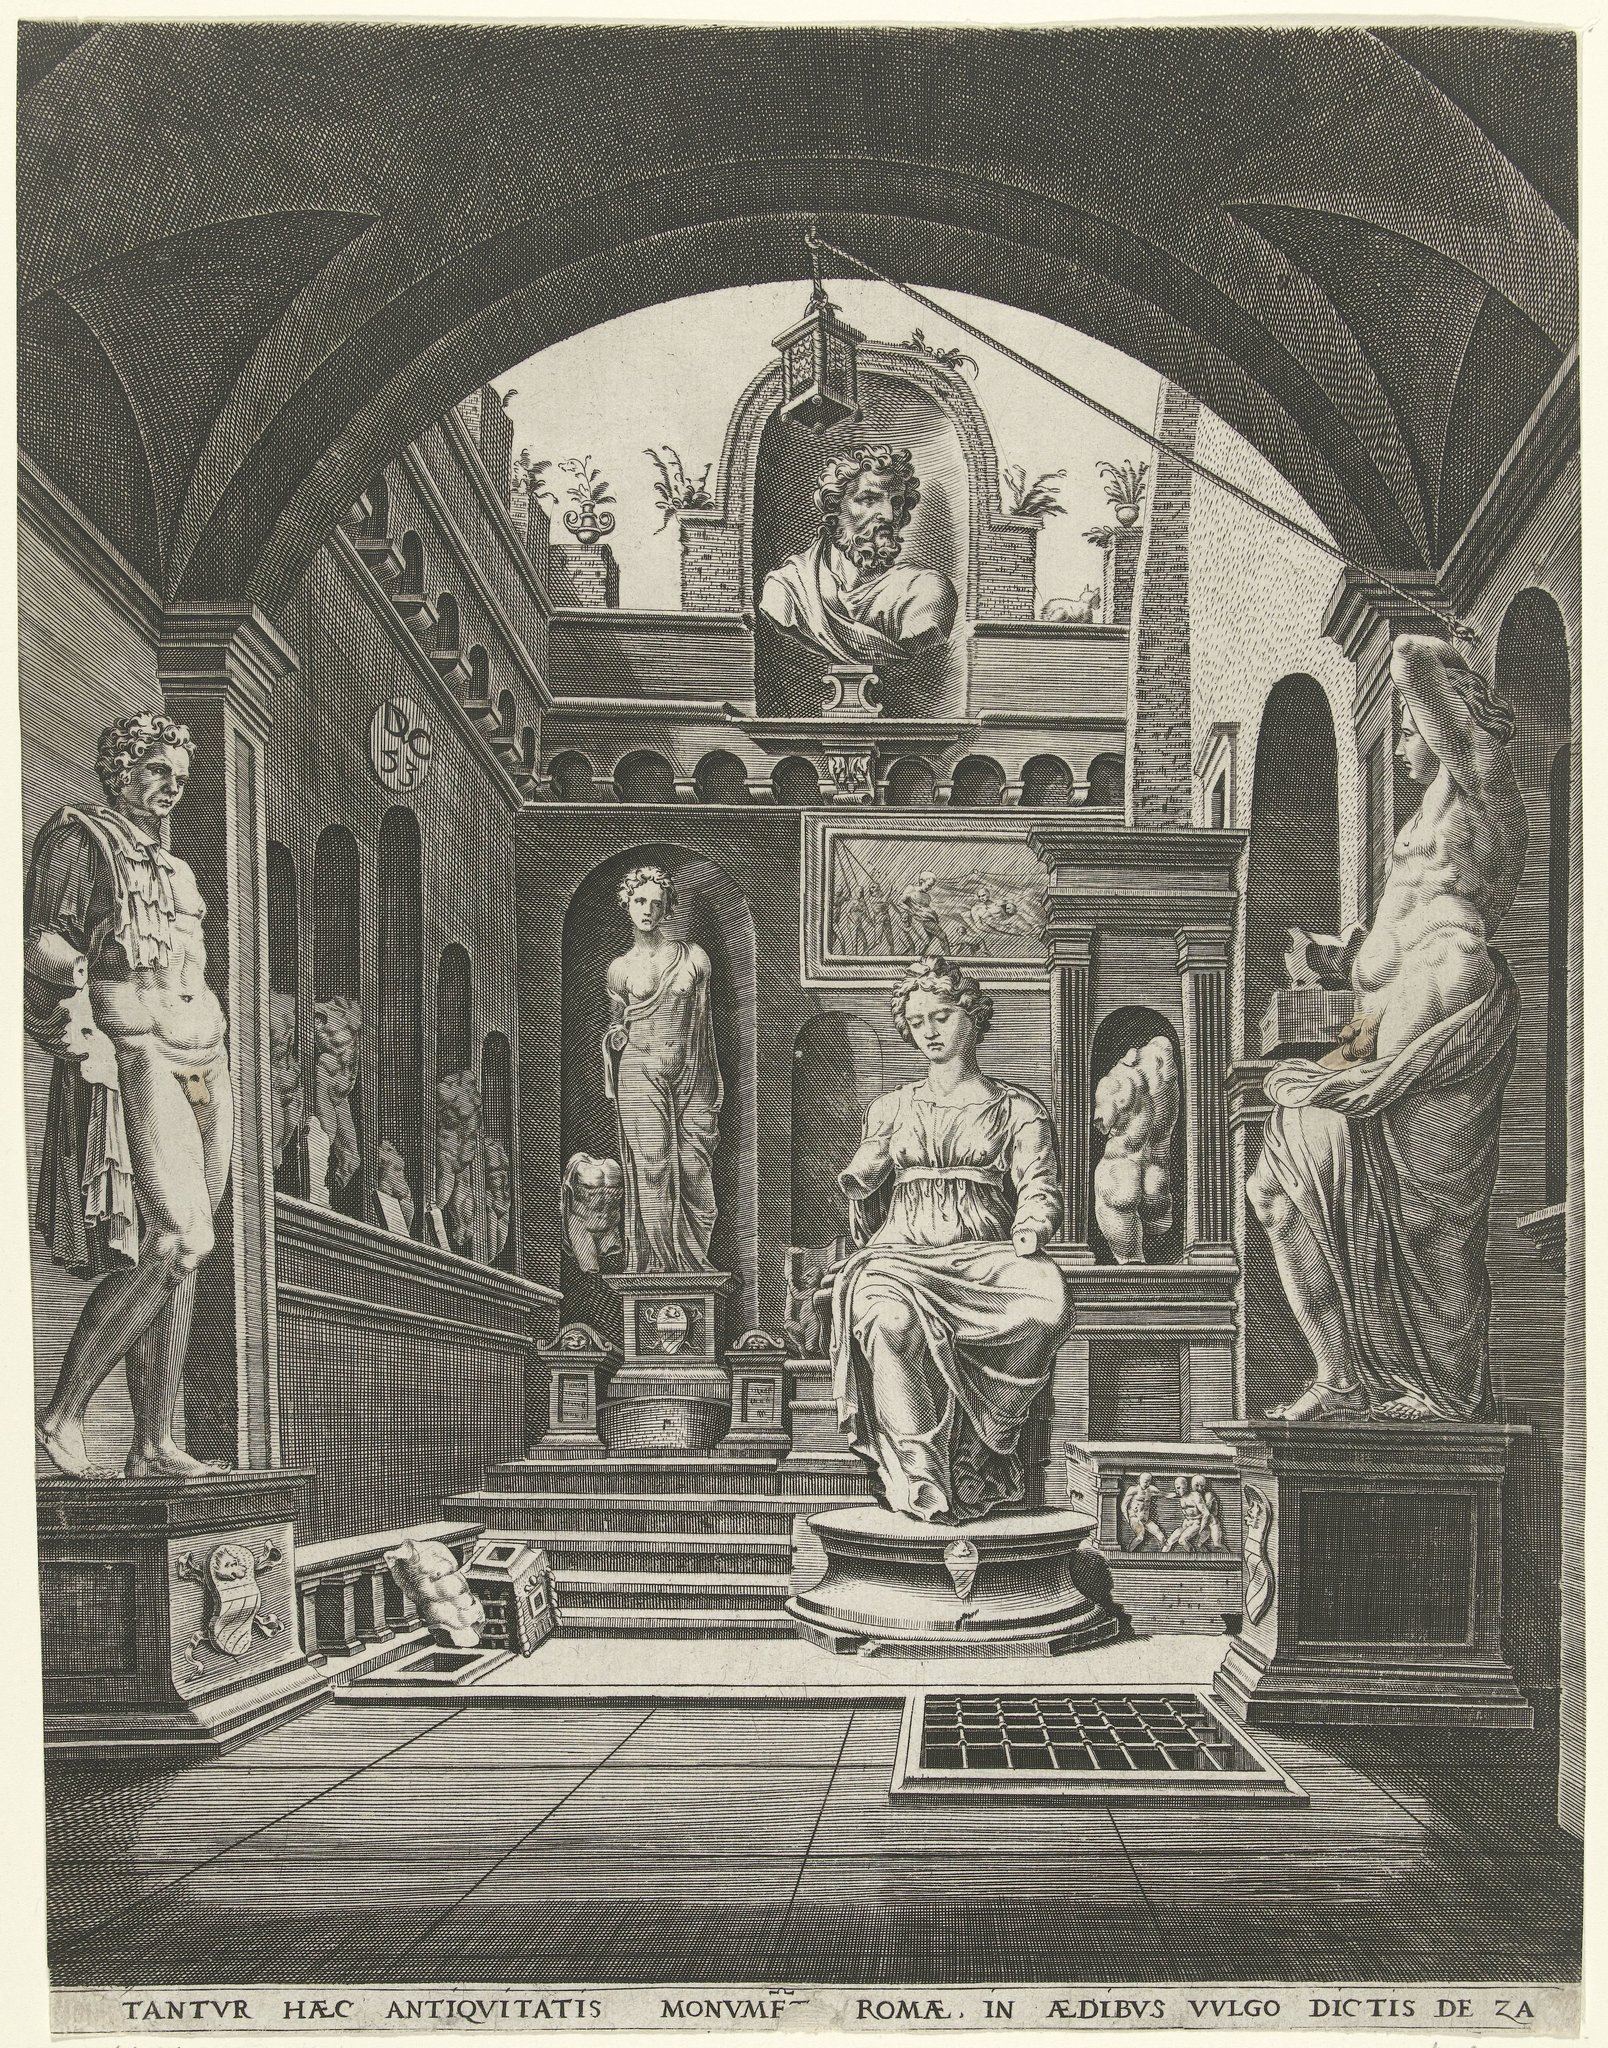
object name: print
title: Beeldenbinnenplaats in de Casa Sassi te Rome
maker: dirck volckertsz. coornhert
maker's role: draughtsman, print maker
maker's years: 1522-1590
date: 1553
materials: paper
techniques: engraving, etching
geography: haarlem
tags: gallery of sculptures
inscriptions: collector's mark: Lugt 11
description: De binnenplaats van de Casa Sassi te Rome, een toentijdse bekende privé-verzameling van antieke beelden. In verschillende niches antieke beeldhouwkunst.